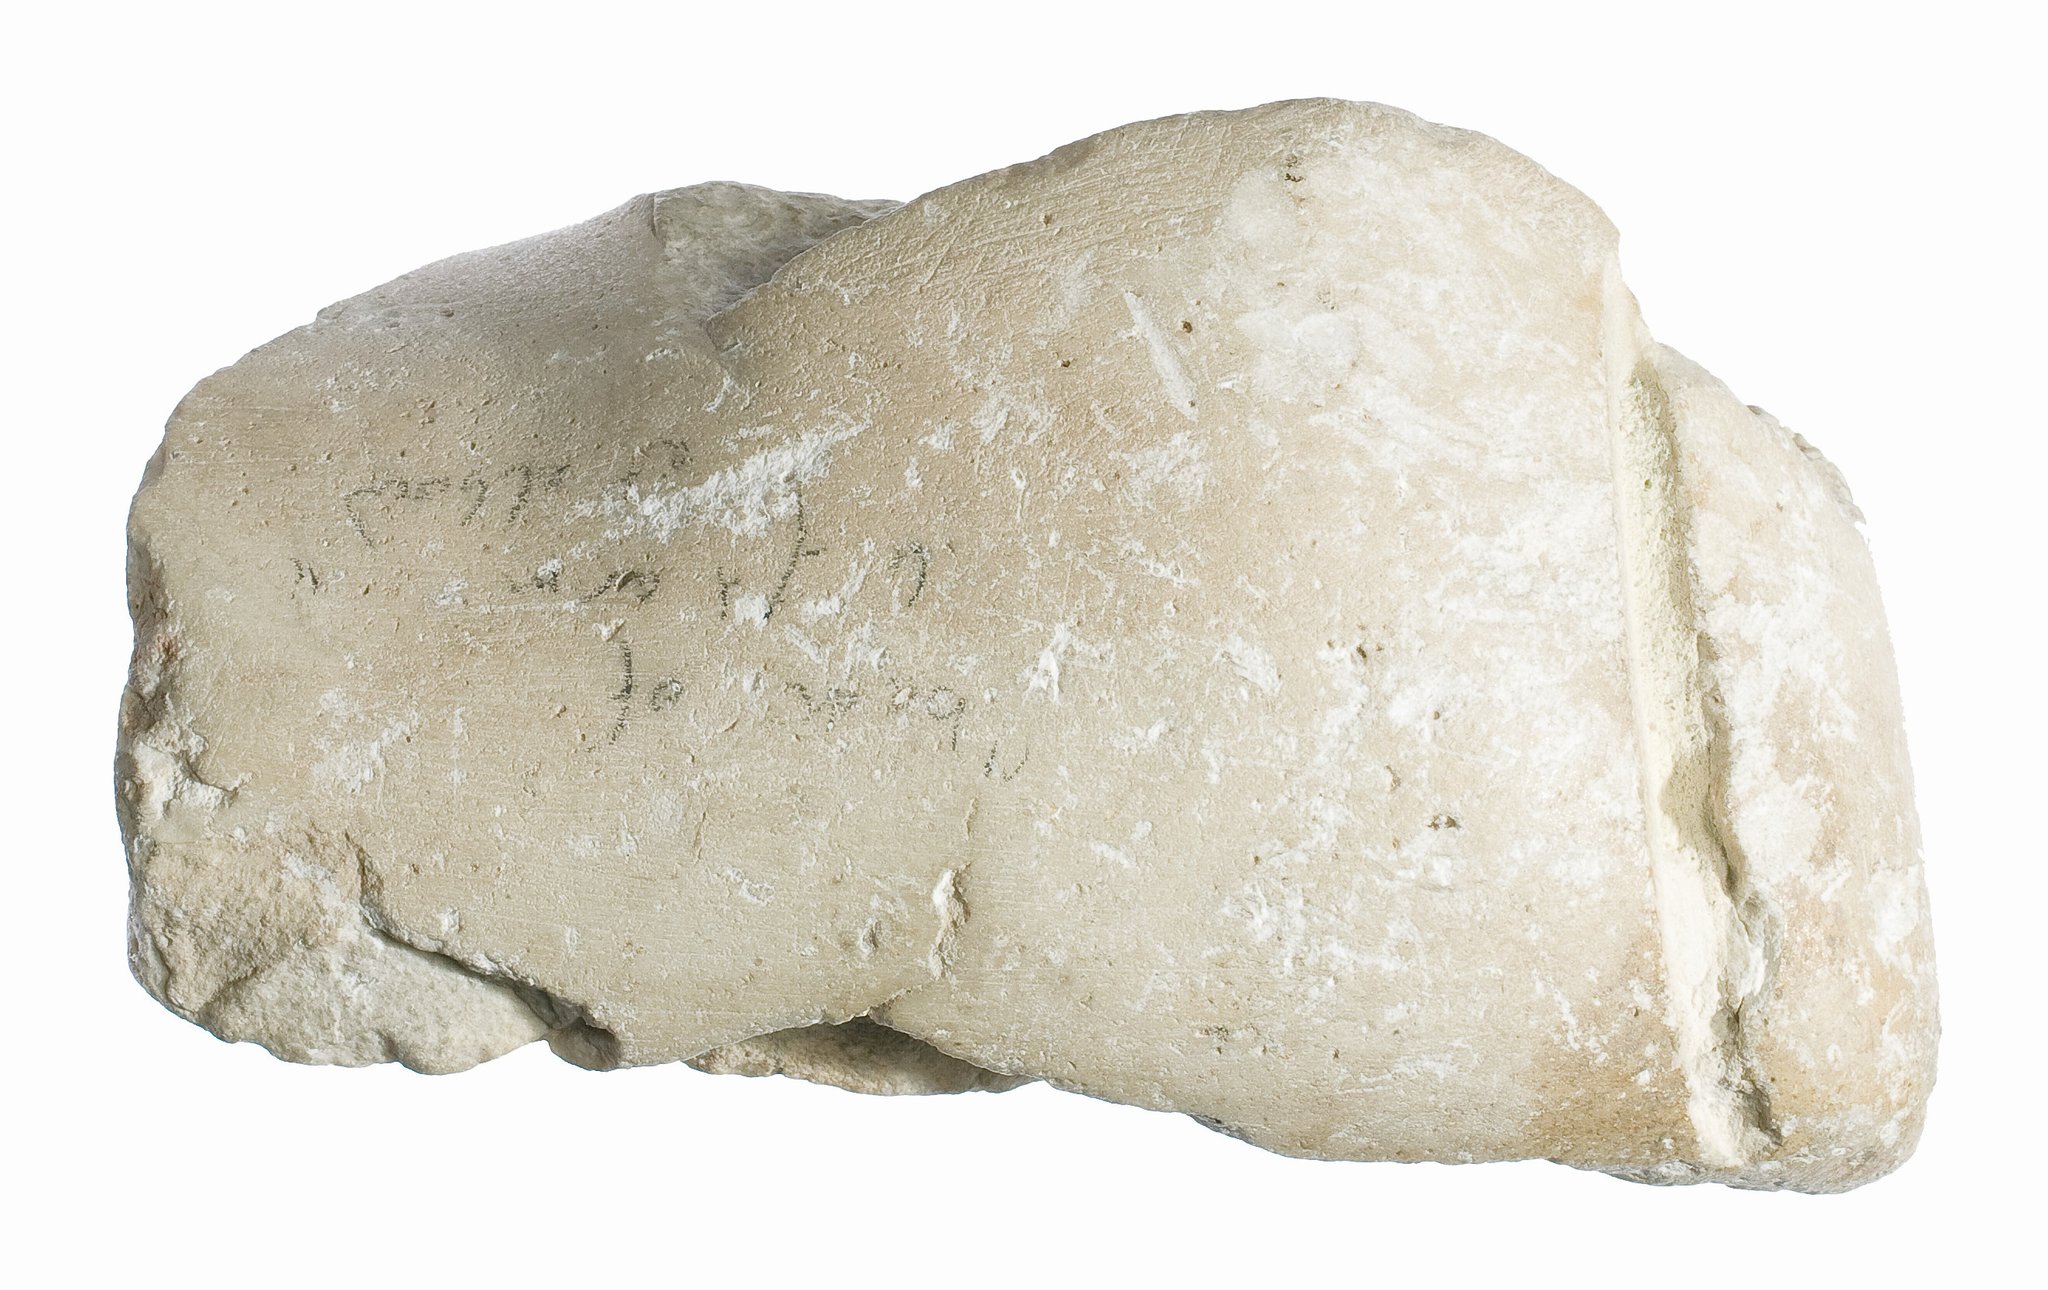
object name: elbow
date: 1353-1336 BCE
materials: limestone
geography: egypt